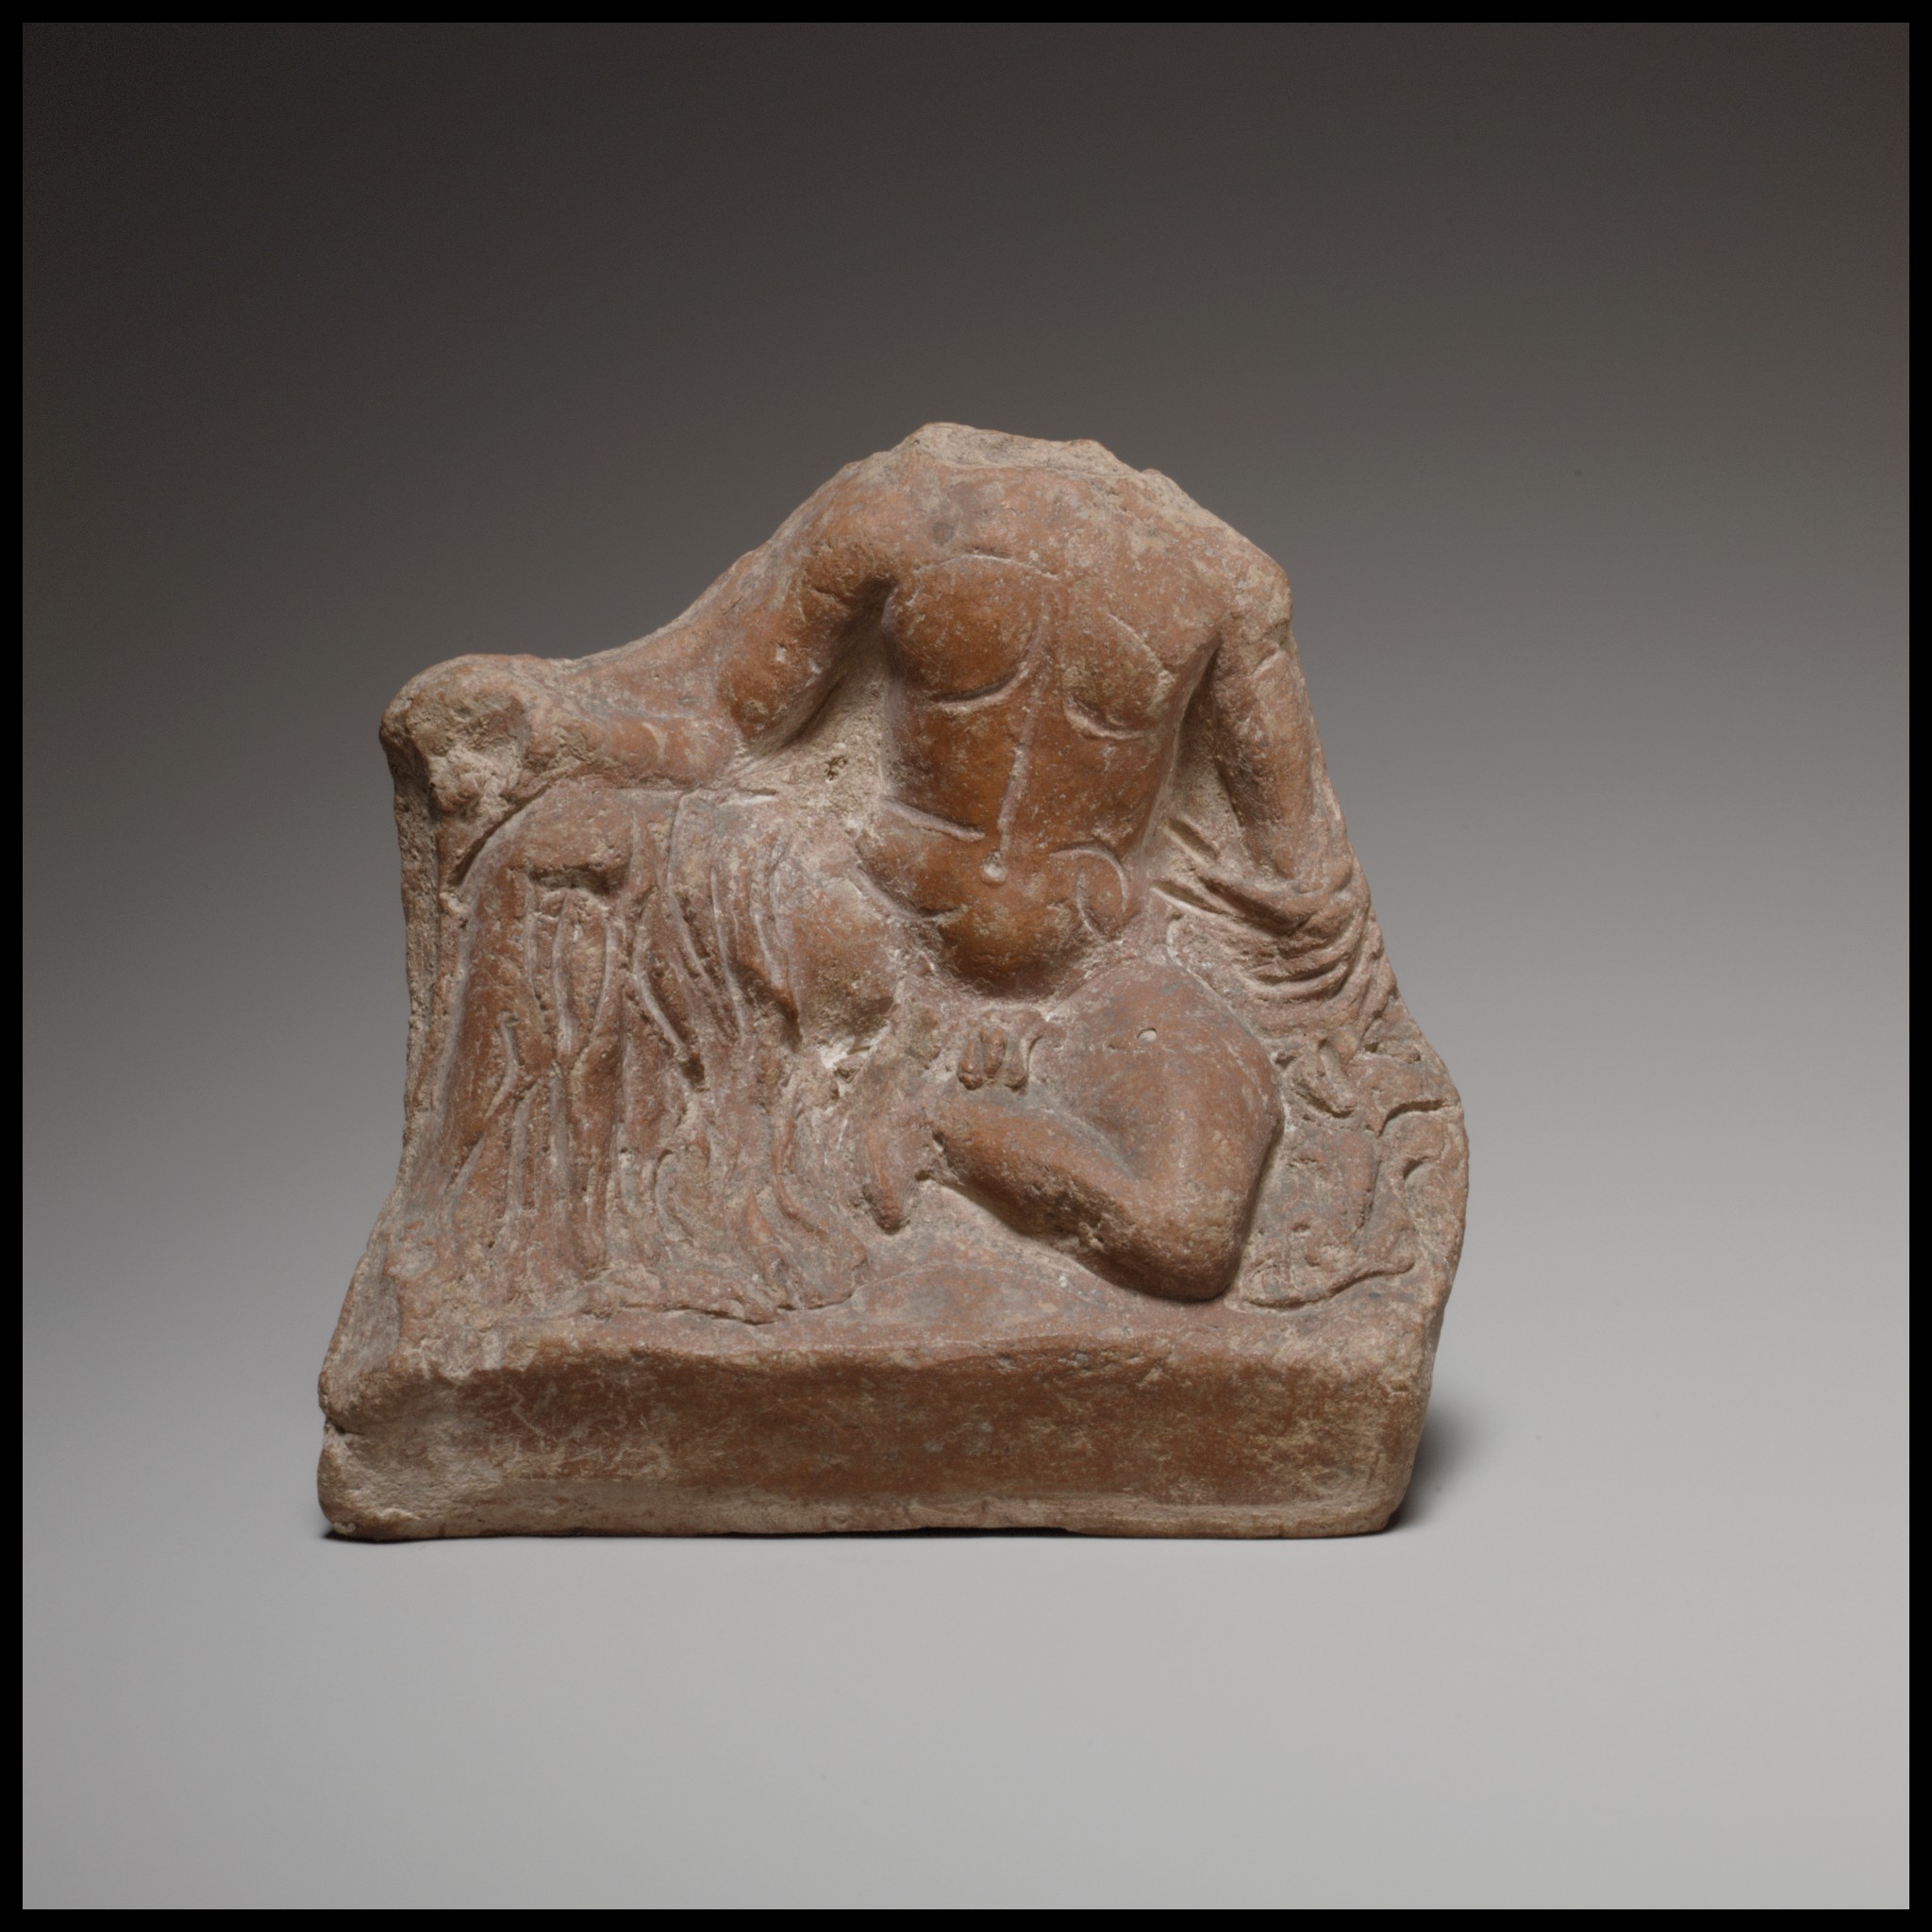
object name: statuette of a temple boy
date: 7000 BCE-330 CE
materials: terracotta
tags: boys